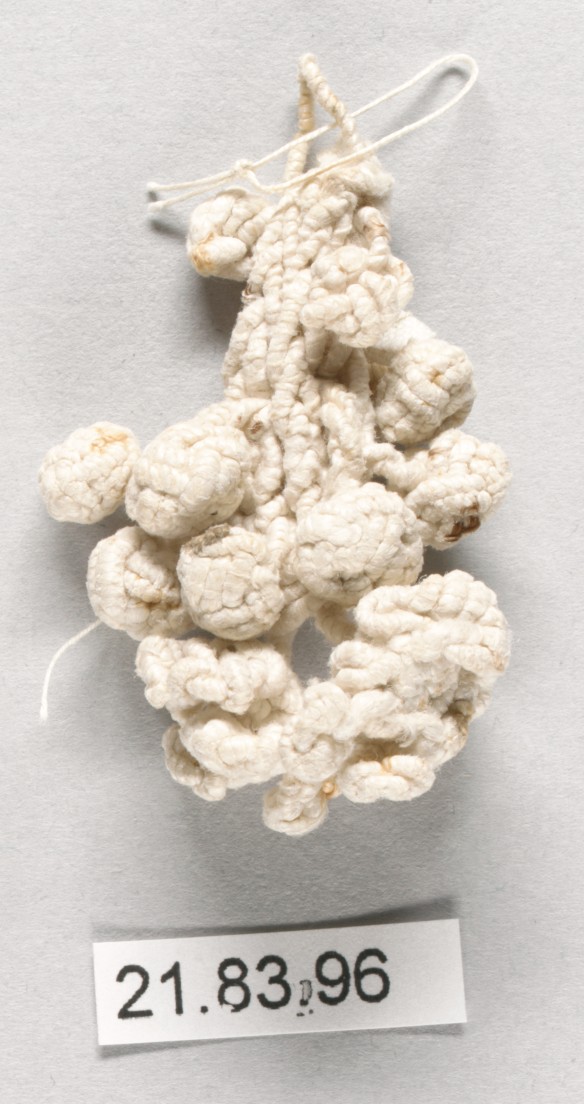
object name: tassel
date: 1601-1700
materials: linen